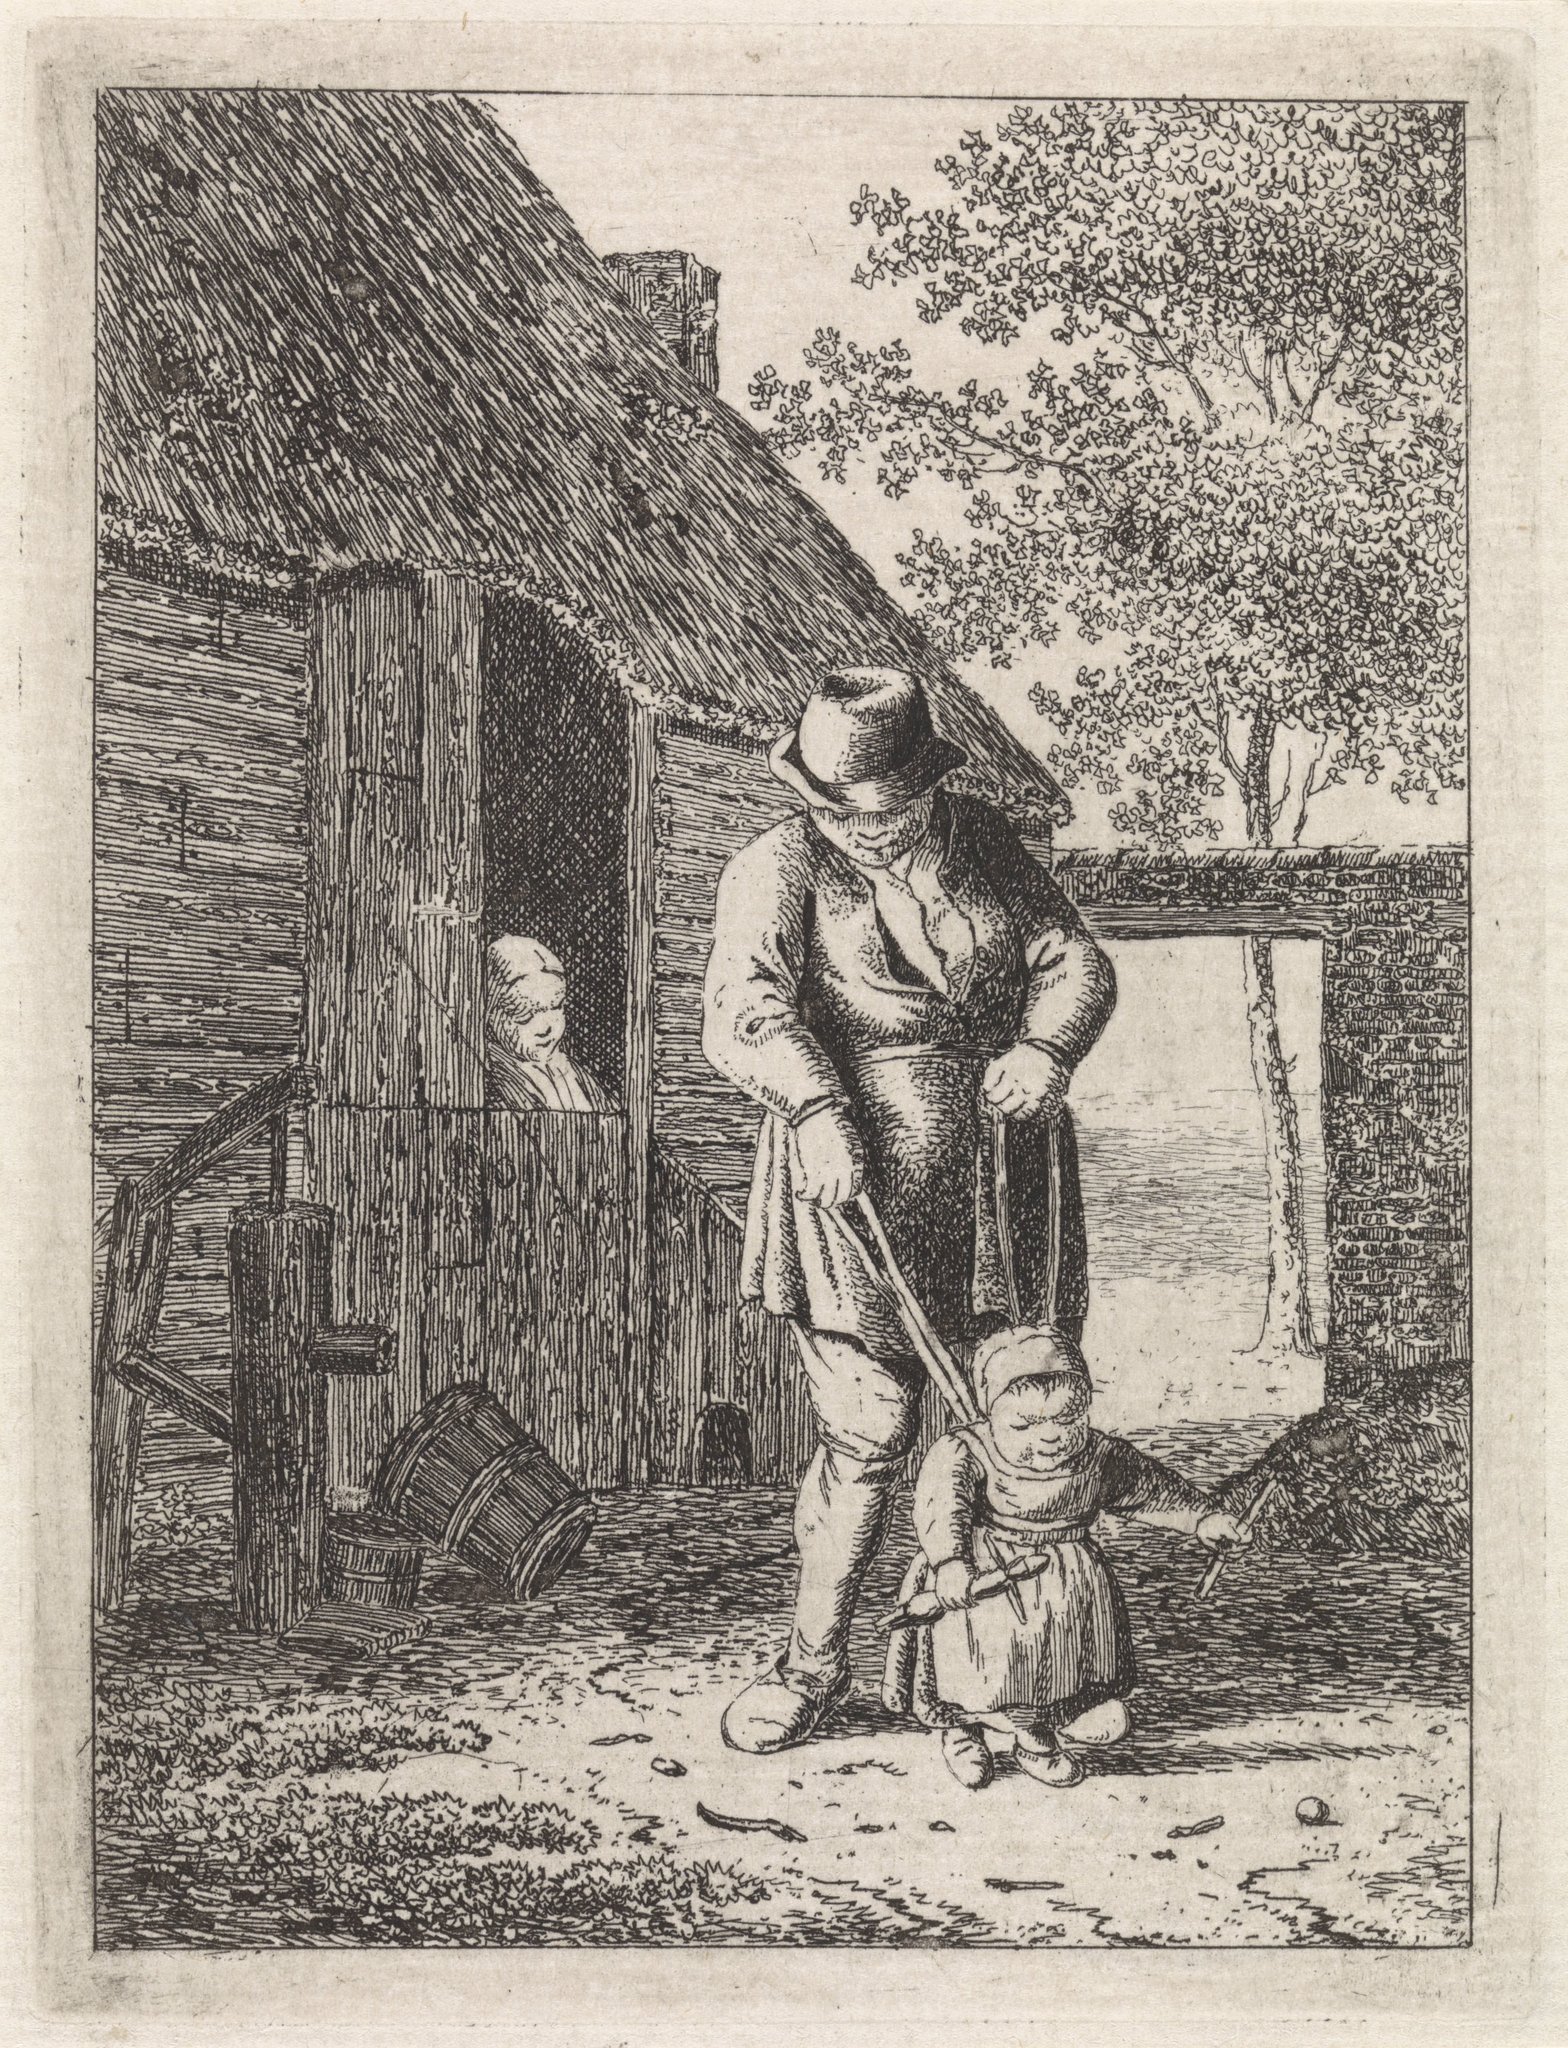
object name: print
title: Boer met kind aan leiband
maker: johannes christiaan janson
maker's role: draughtsman, painter, print maker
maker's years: 1763-1823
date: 1778-1823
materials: paper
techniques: etching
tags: pump, learning to walk, the first steps, father and child(ren), man and child(ren) (family group)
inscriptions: collector's mark: Lugt 2228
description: Erf met een boer die een kind aan de leiband houdt. Achter hen een boerderij met boerin in de deuropening. Voor de boerderij een waterpomp en emmers.